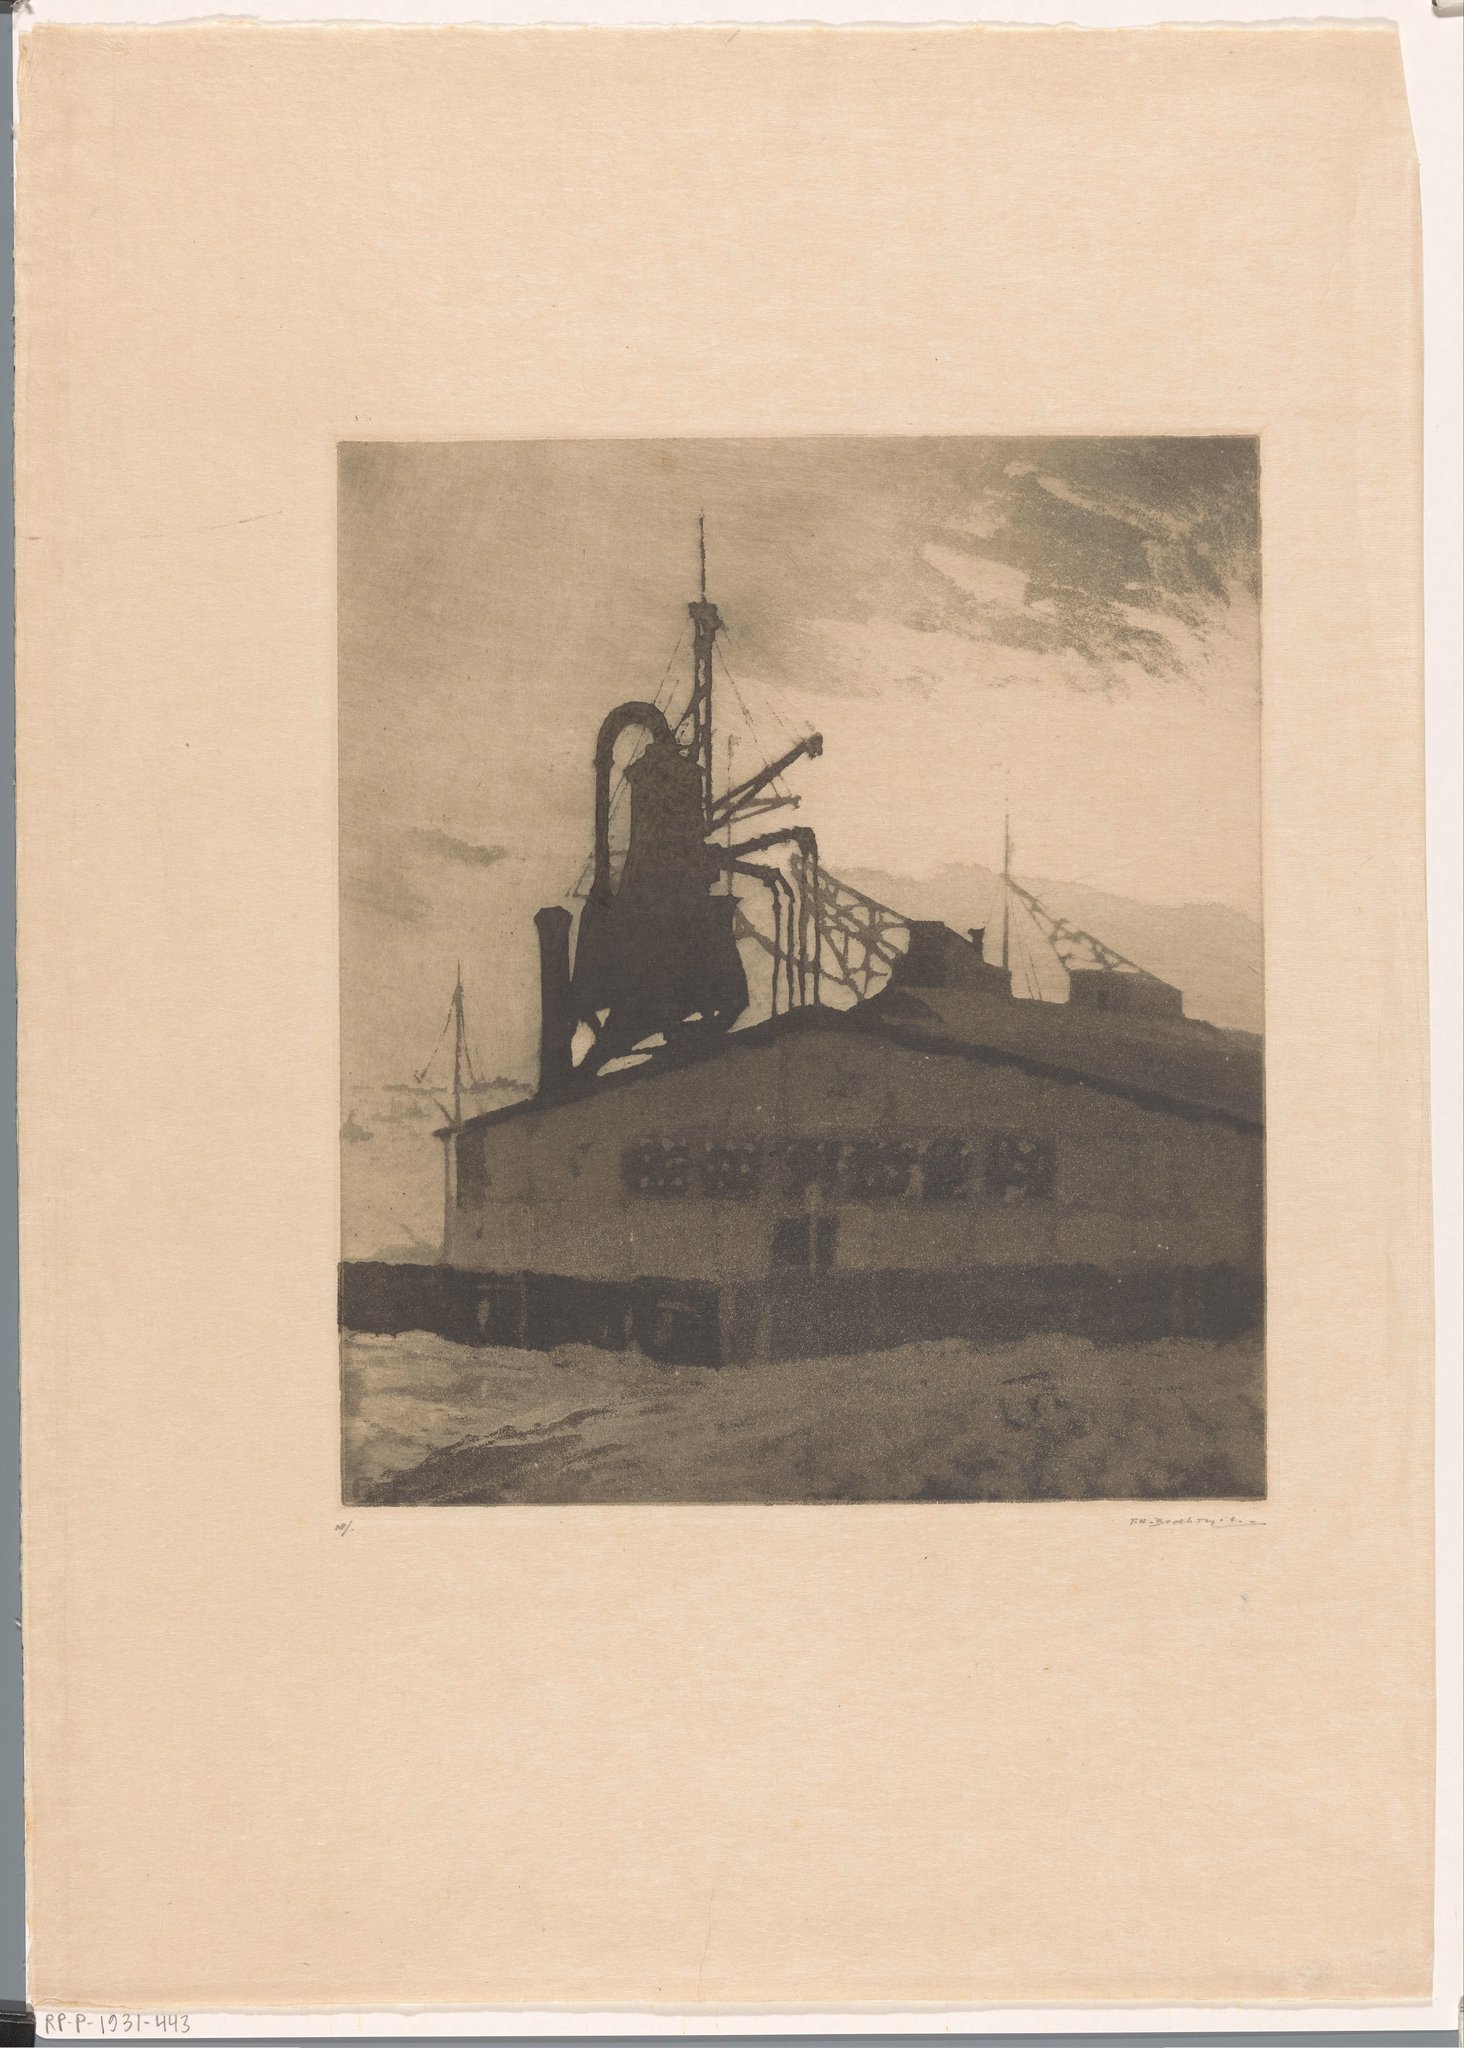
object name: print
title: Elevator naast een loods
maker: frederika henriëtte broeksmit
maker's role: draughtsman, print maker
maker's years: 1875-1945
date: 1885-1931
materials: paper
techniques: aquatint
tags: large-scale structure for storage, e.g.: warehouse, depot, silo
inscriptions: collector's mark: Lugt 2228